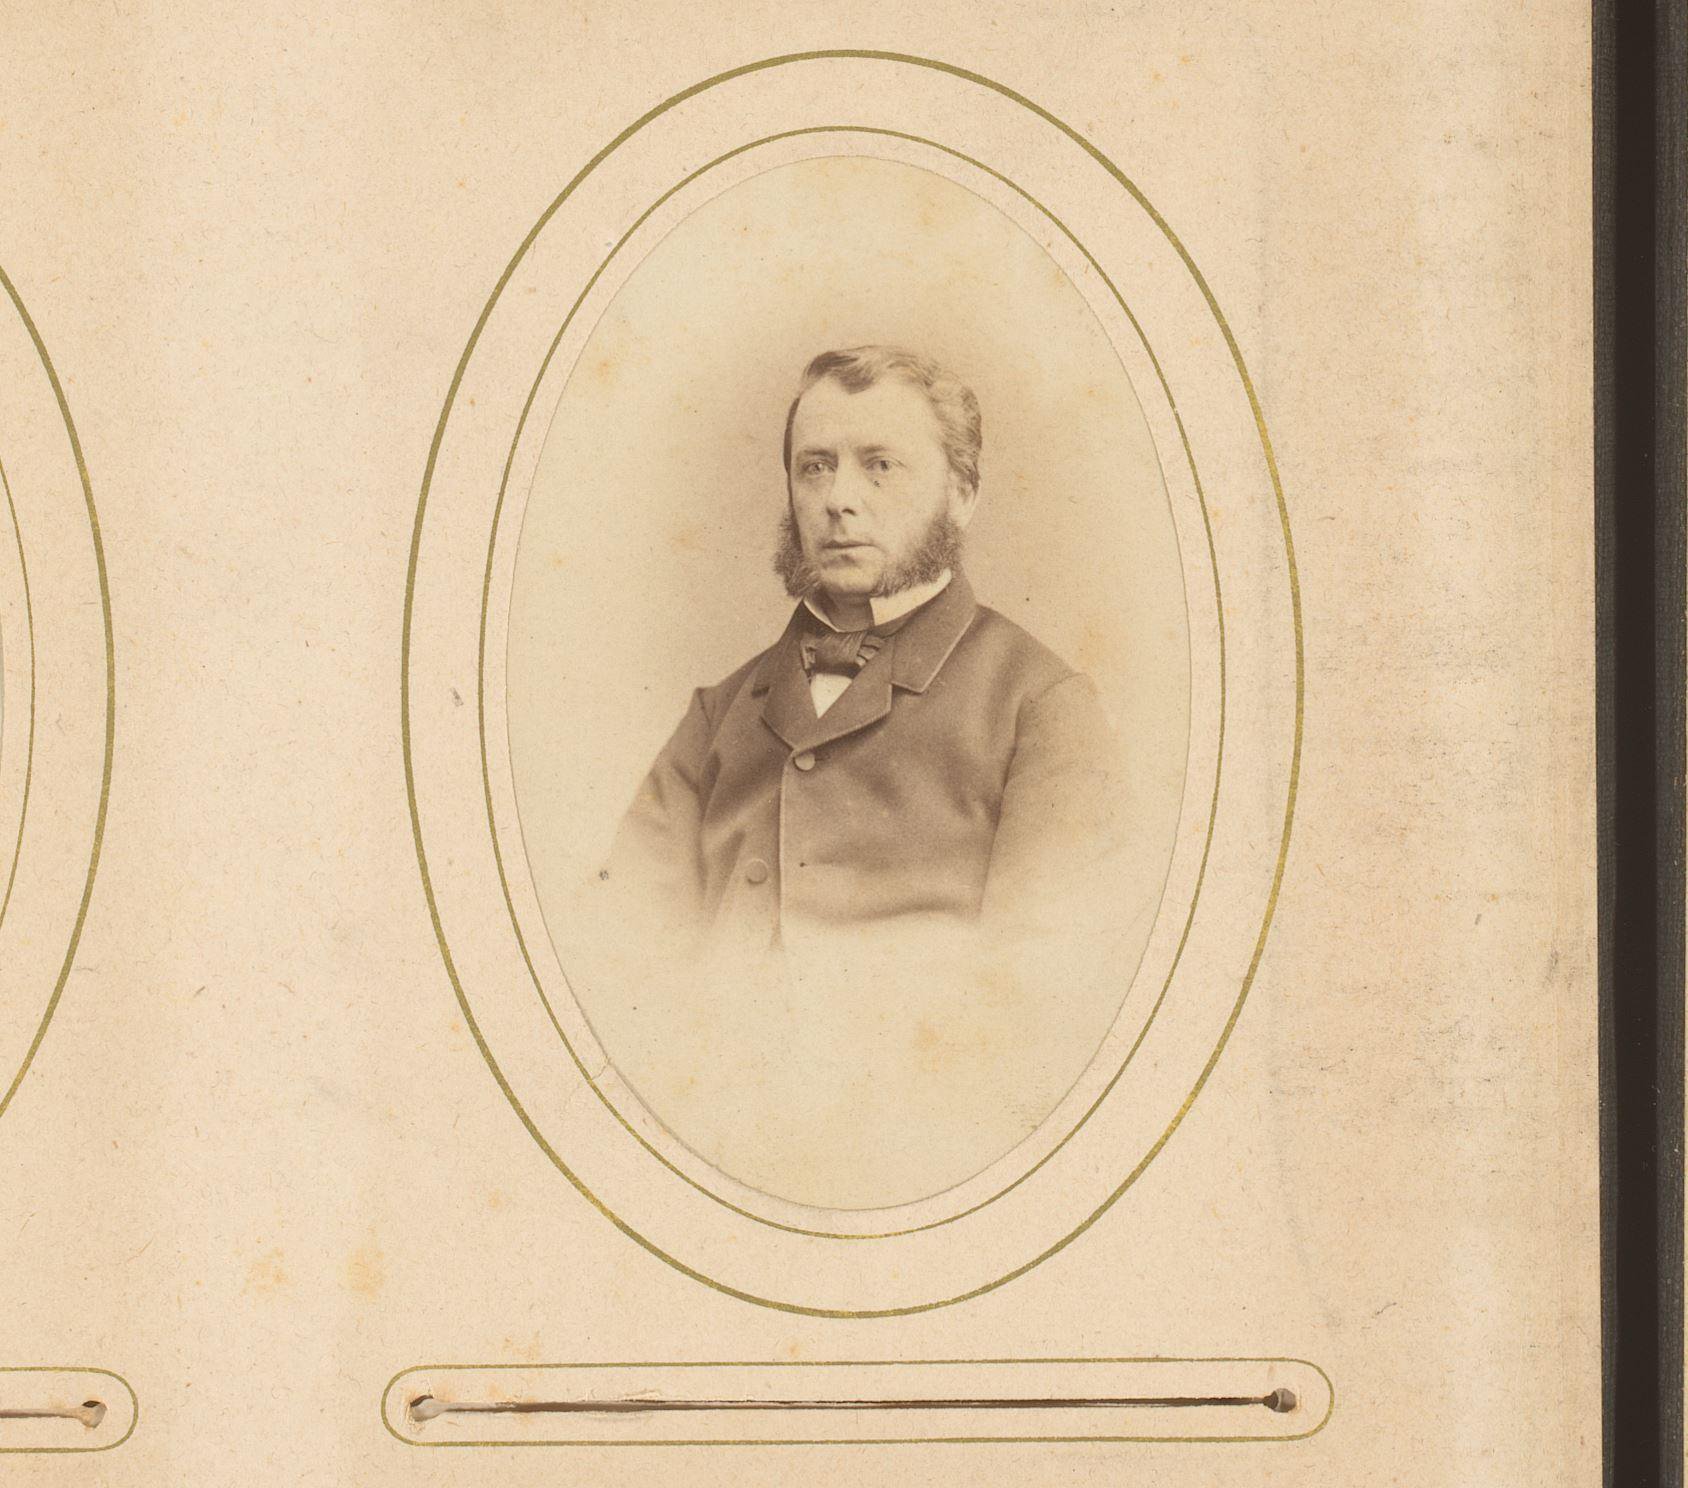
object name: carte de visite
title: Portret van een zittende man met bakkebaarden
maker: hermanus philippus jacobus schuiten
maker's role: fotograaf, lijstenmaker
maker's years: 1820-1869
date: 1850-1869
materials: cardboard, photographic support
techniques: albumen print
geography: amsterdam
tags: sideburns, sitting figure, historical persons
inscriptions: inscription: ‘Atelier de Photographie/ H.PH.J. SCHUITEN/ AMSTERDAM’